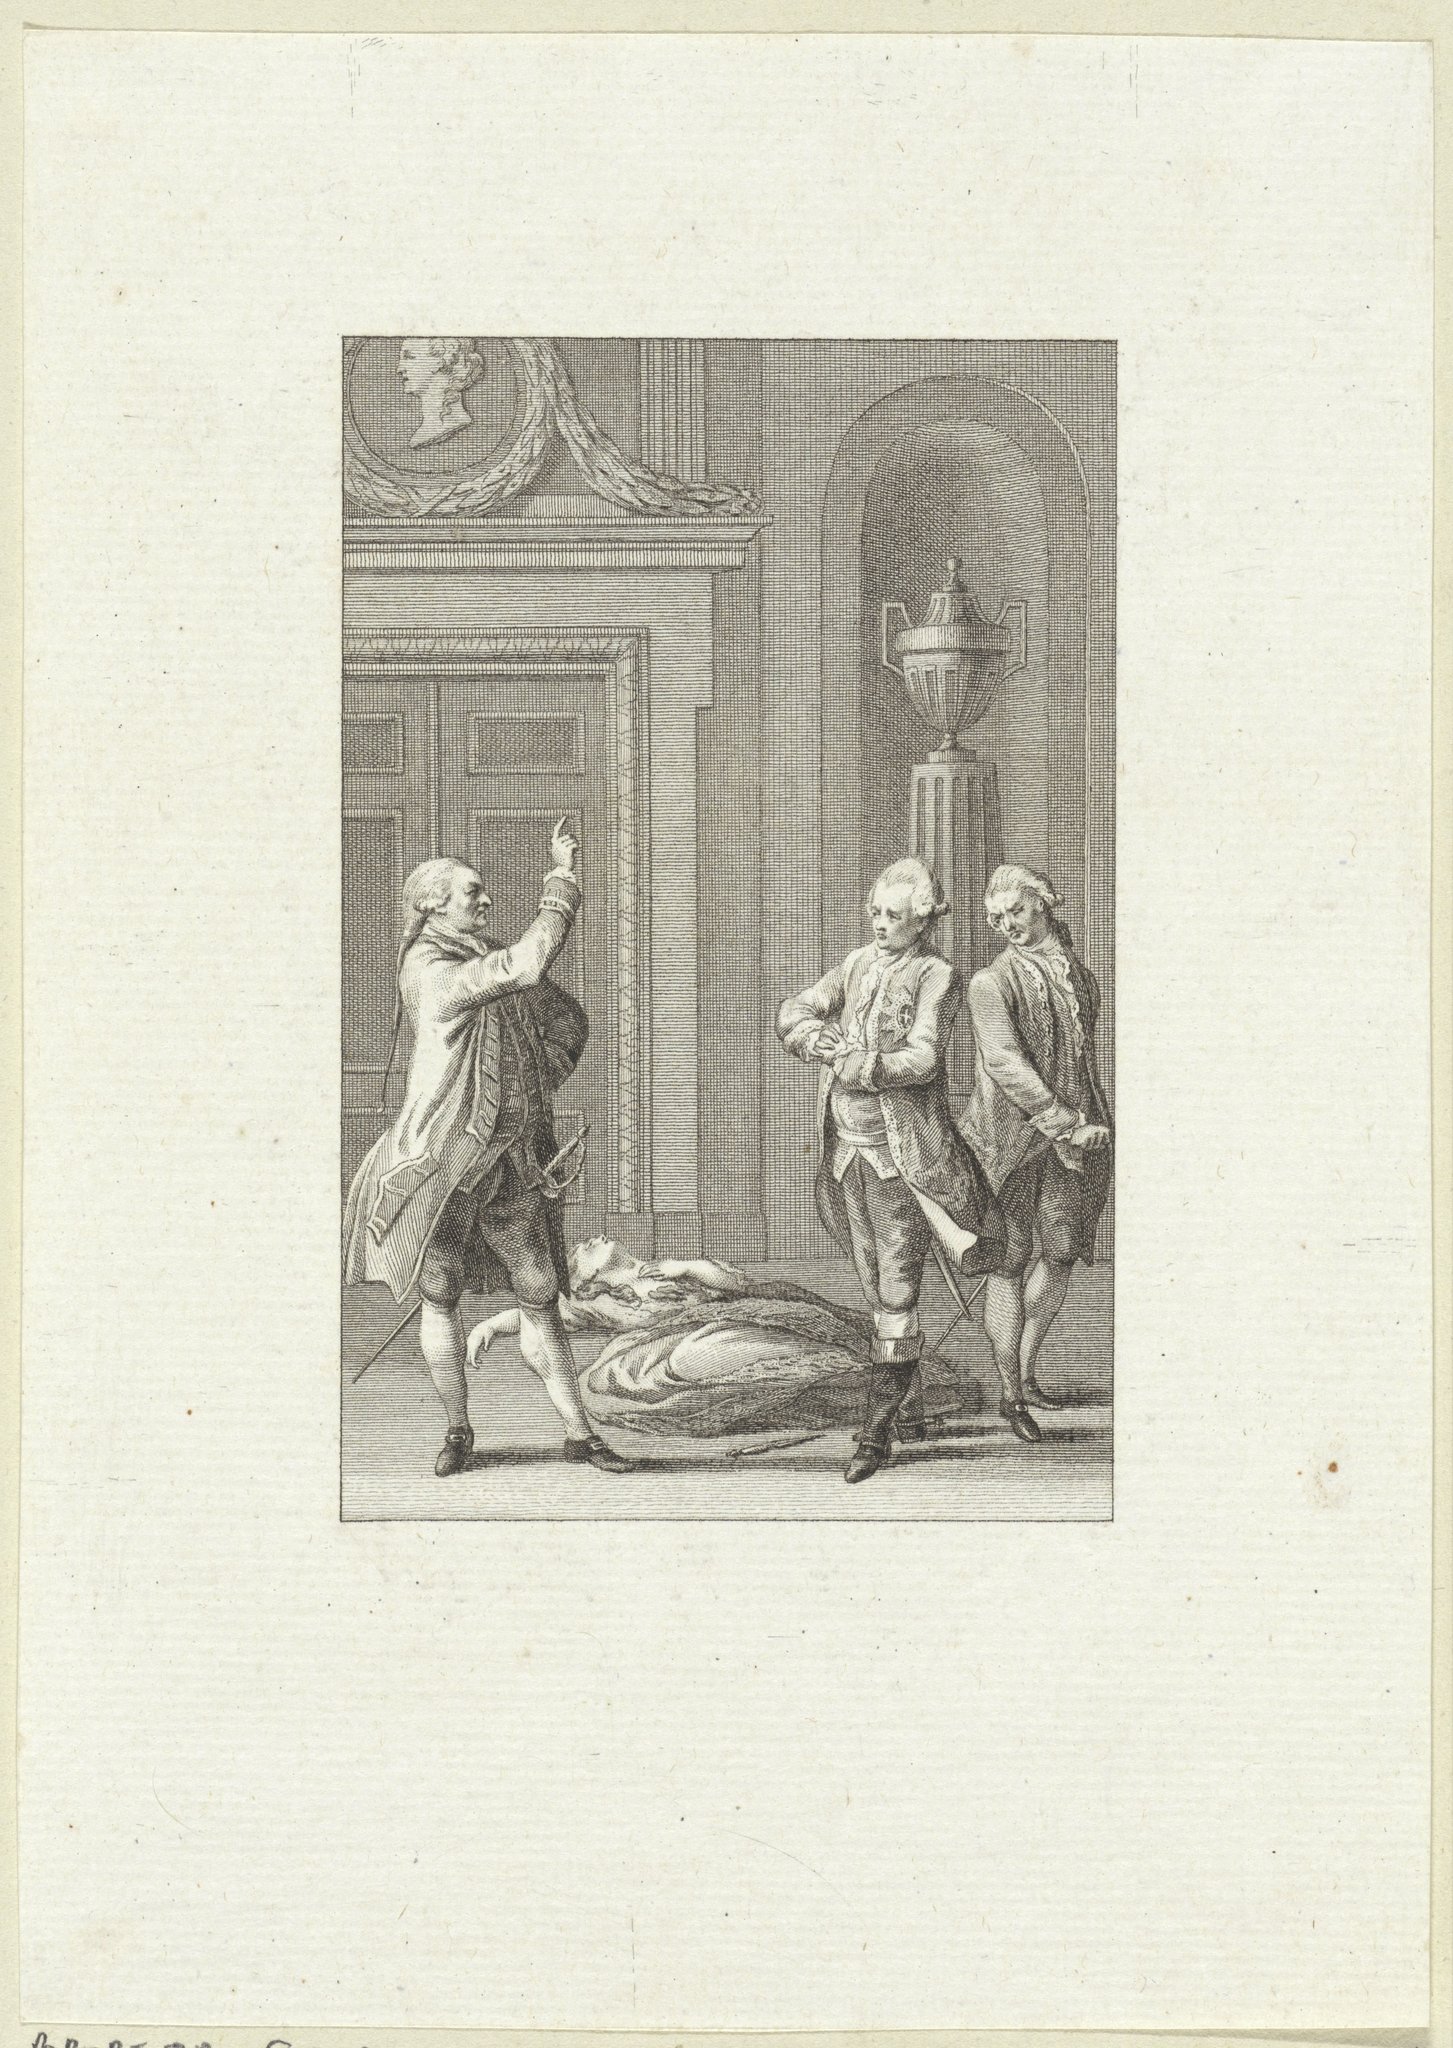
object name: print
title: Man berispt een andere man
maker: reinier vinkeles (i)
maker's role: draughtsman, print maker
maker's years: 1741-1816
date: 1777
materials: paper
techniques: engraving, etching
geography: amsterdam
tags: fainting, swooning, hacking and thrusting weapons: dagger, accusing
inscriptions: collector's mark: Lugt 240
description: Proefdruk van illustratie die mogelijk is gebruikt in: Lessing, Gotthold Ephraim. Emilia Galotti. Amsterdam: Pieter Meijer, 1777.